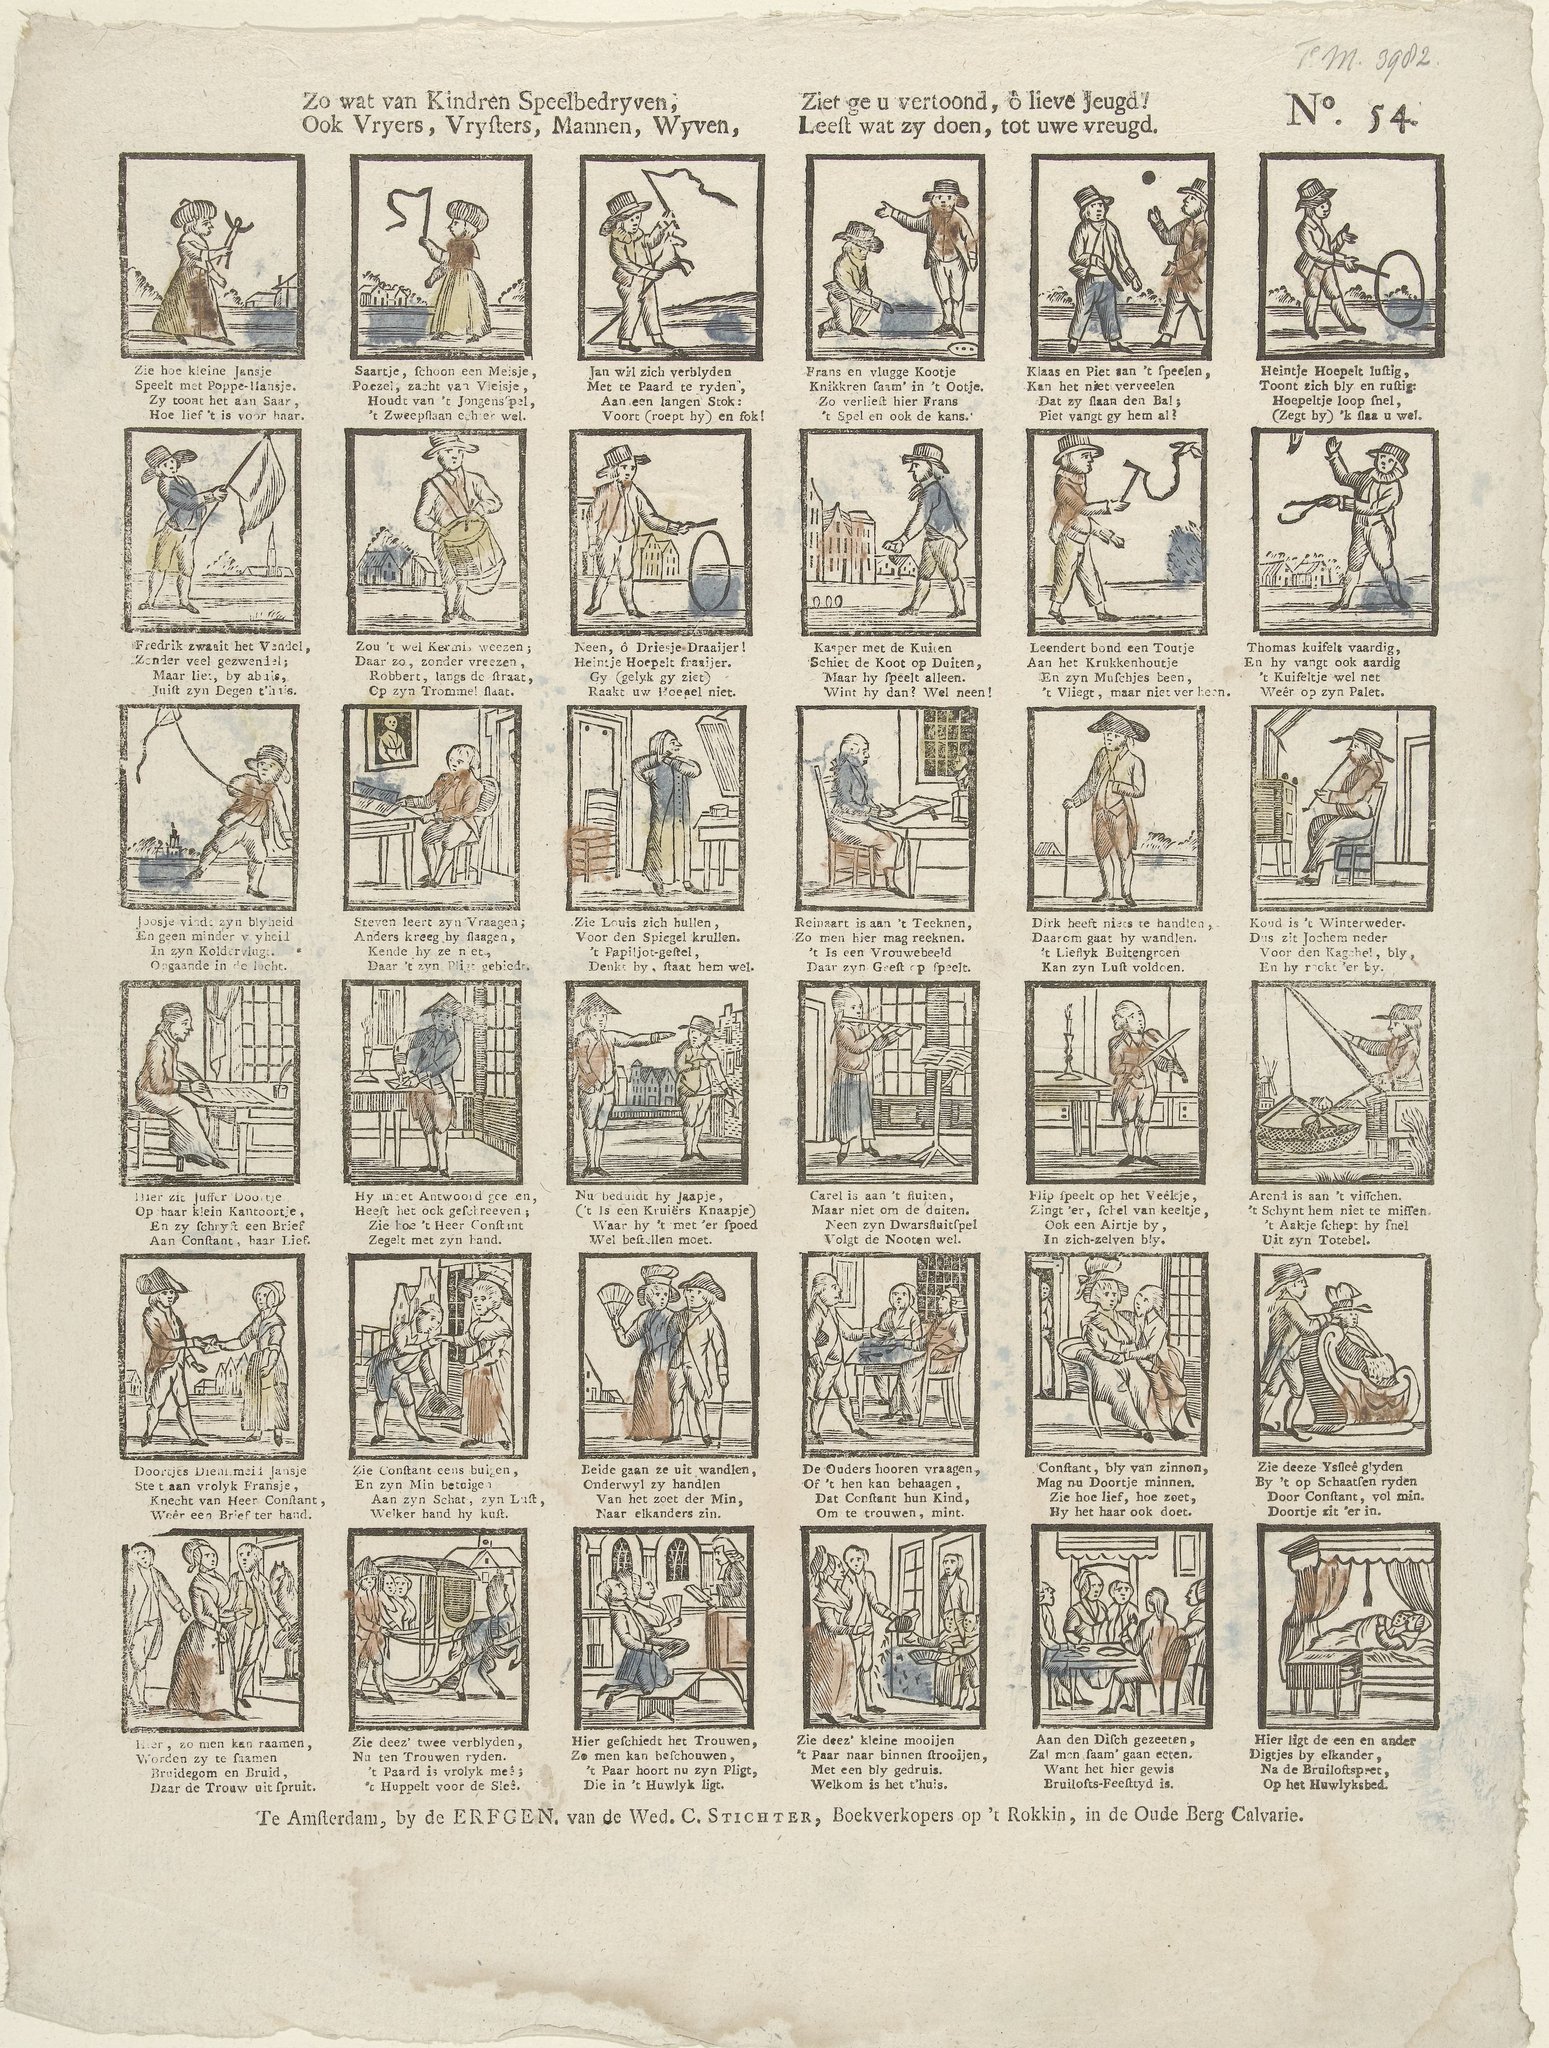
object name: print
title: Zo wat van kindren speelbedryven, / Ook vryers, vrysters, mannen, wyven, / Ziet ge u vertoond, ô lieve jeugd! / Leest wat zy doen, tot uwe vreugd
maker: Anonymous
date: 1770-1797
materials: paper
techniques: colour, letterpress printing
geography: amsterdam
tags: children's games and plays, (flying a) kite, games using special objects (marbles, top, hoop, etc.)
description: Blad met 36 voorstellingen van kinderspelen en bezigheden, zoals stokpaardje rijden, hoepelen, vliegeren en vissen. Onder elke afbeelding een vierregelig vers. Genummerd rechtsboven: No. 54.